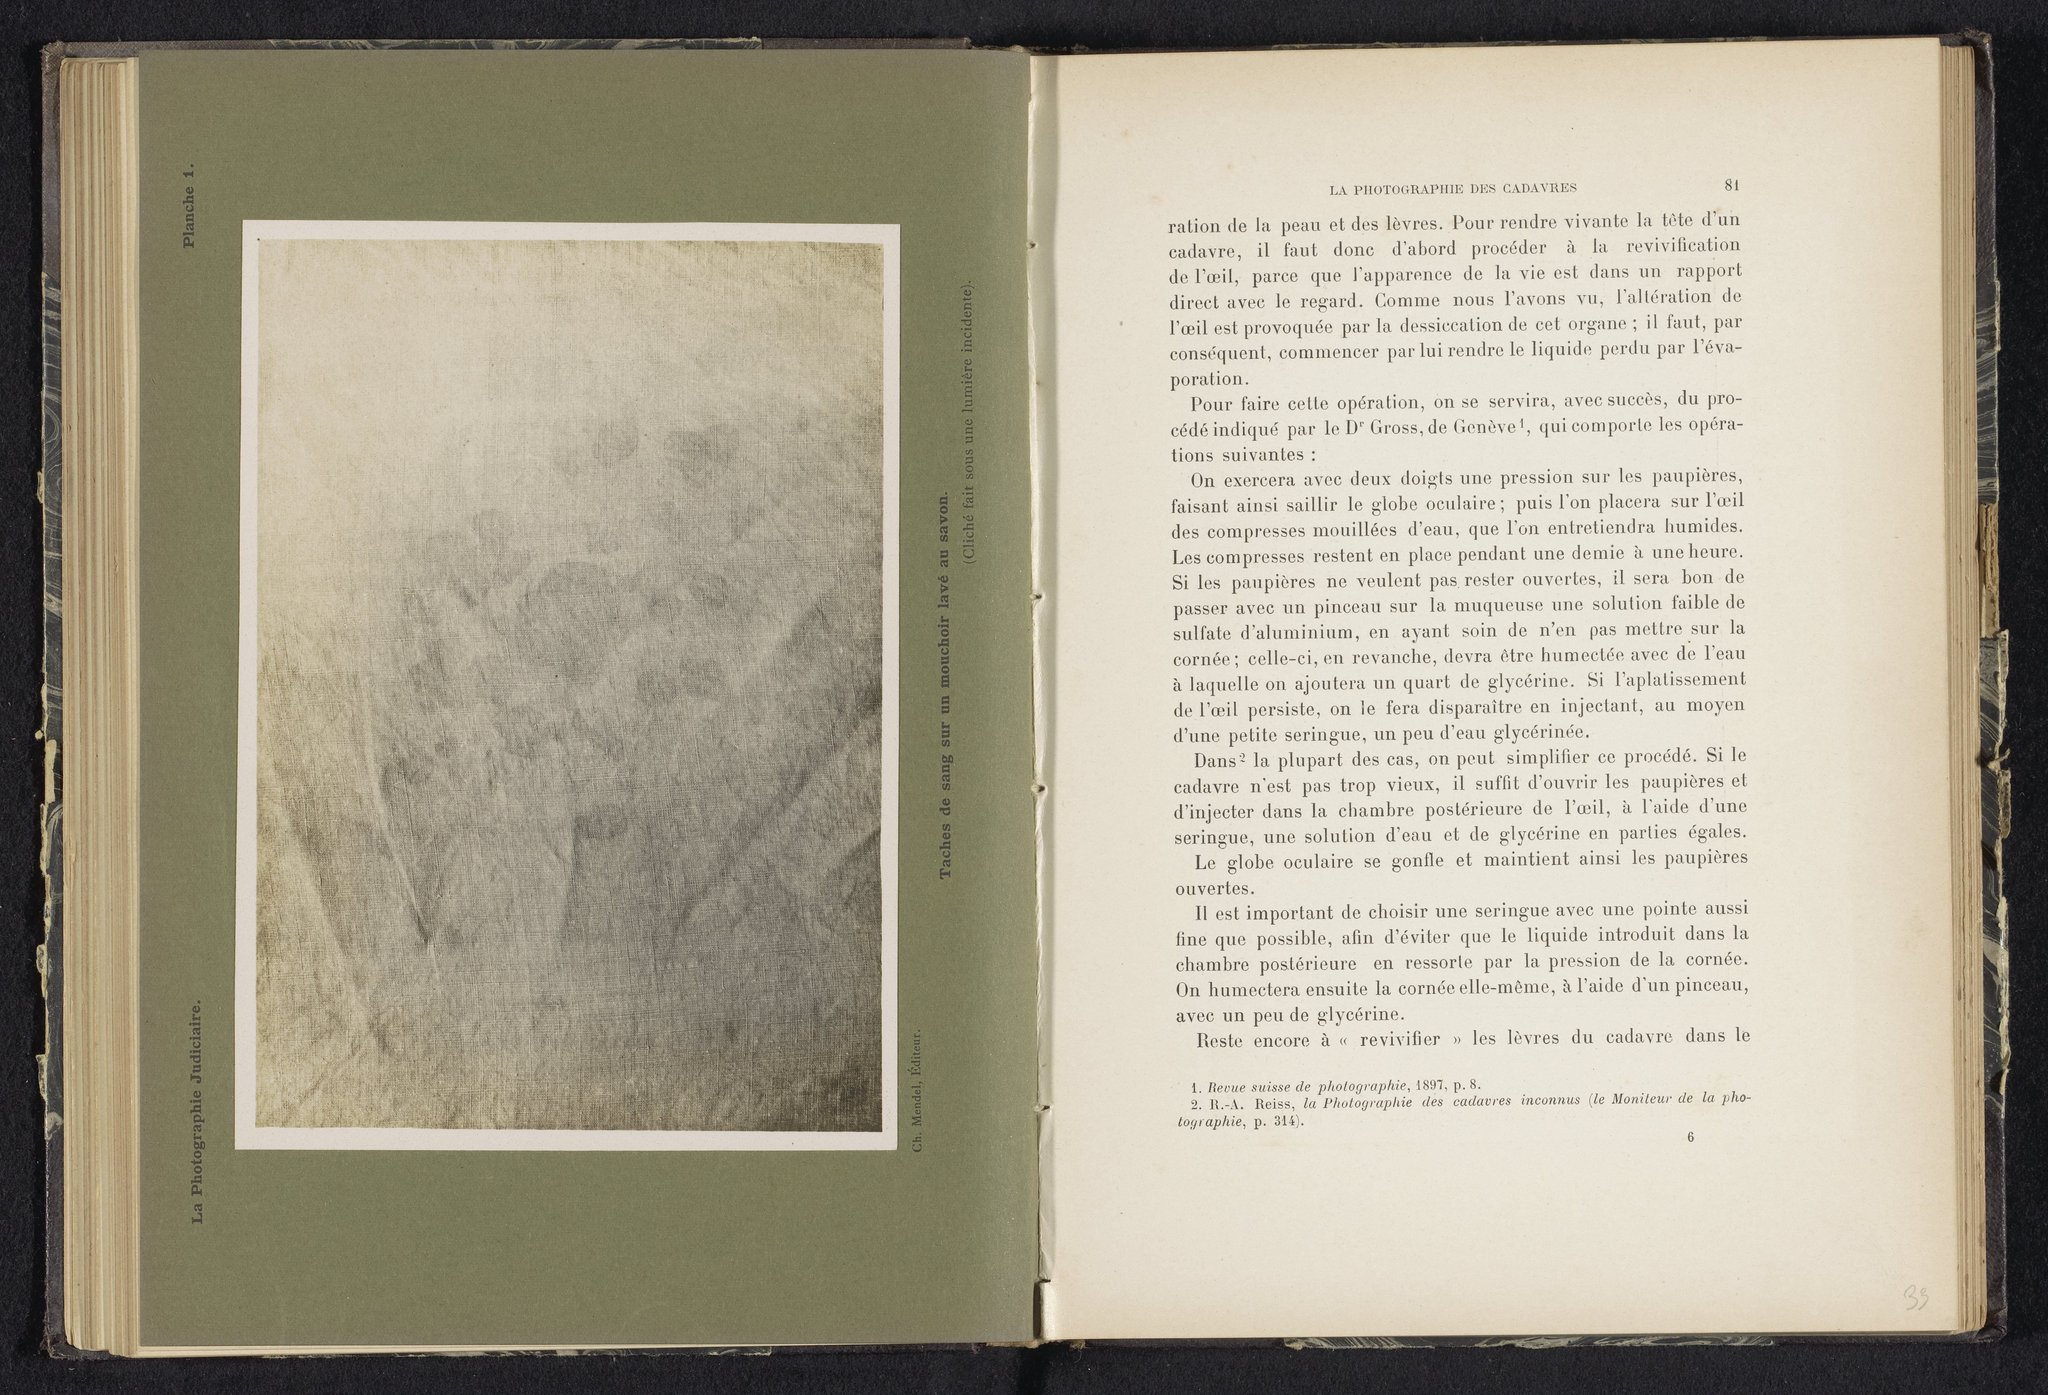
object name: page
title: Bloedspetters op een met zeep gewassen zakdoek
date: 1893-1903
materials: photographic support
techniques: gelatin silver print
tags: blood, handkerchief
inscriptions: inscription: ‘(Cliché fait sous une lumière incidente)’, number: ‘Planche 1.’